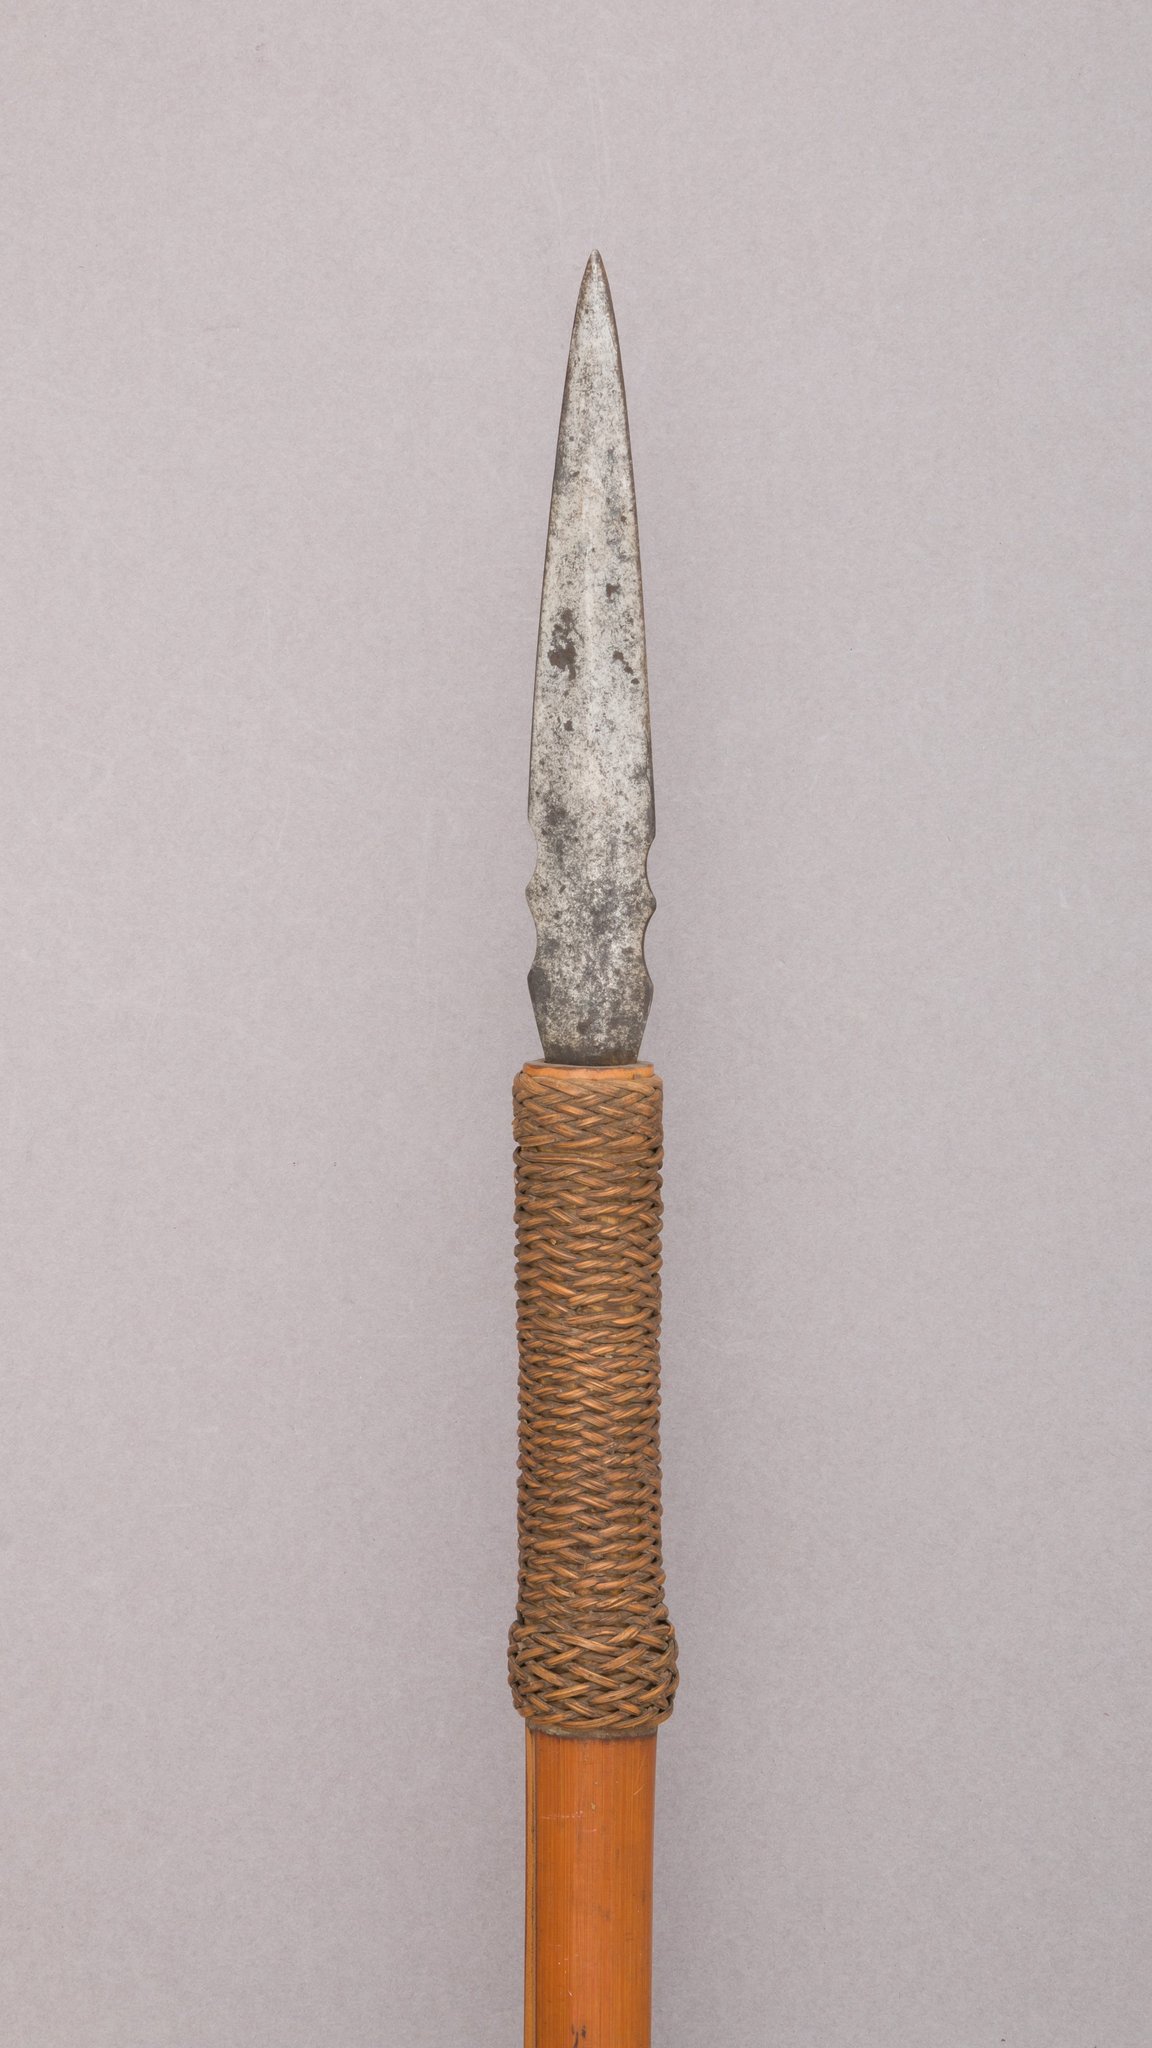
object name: spear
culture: taiwanese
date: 1801-1900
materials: steel, wood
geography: taiwan